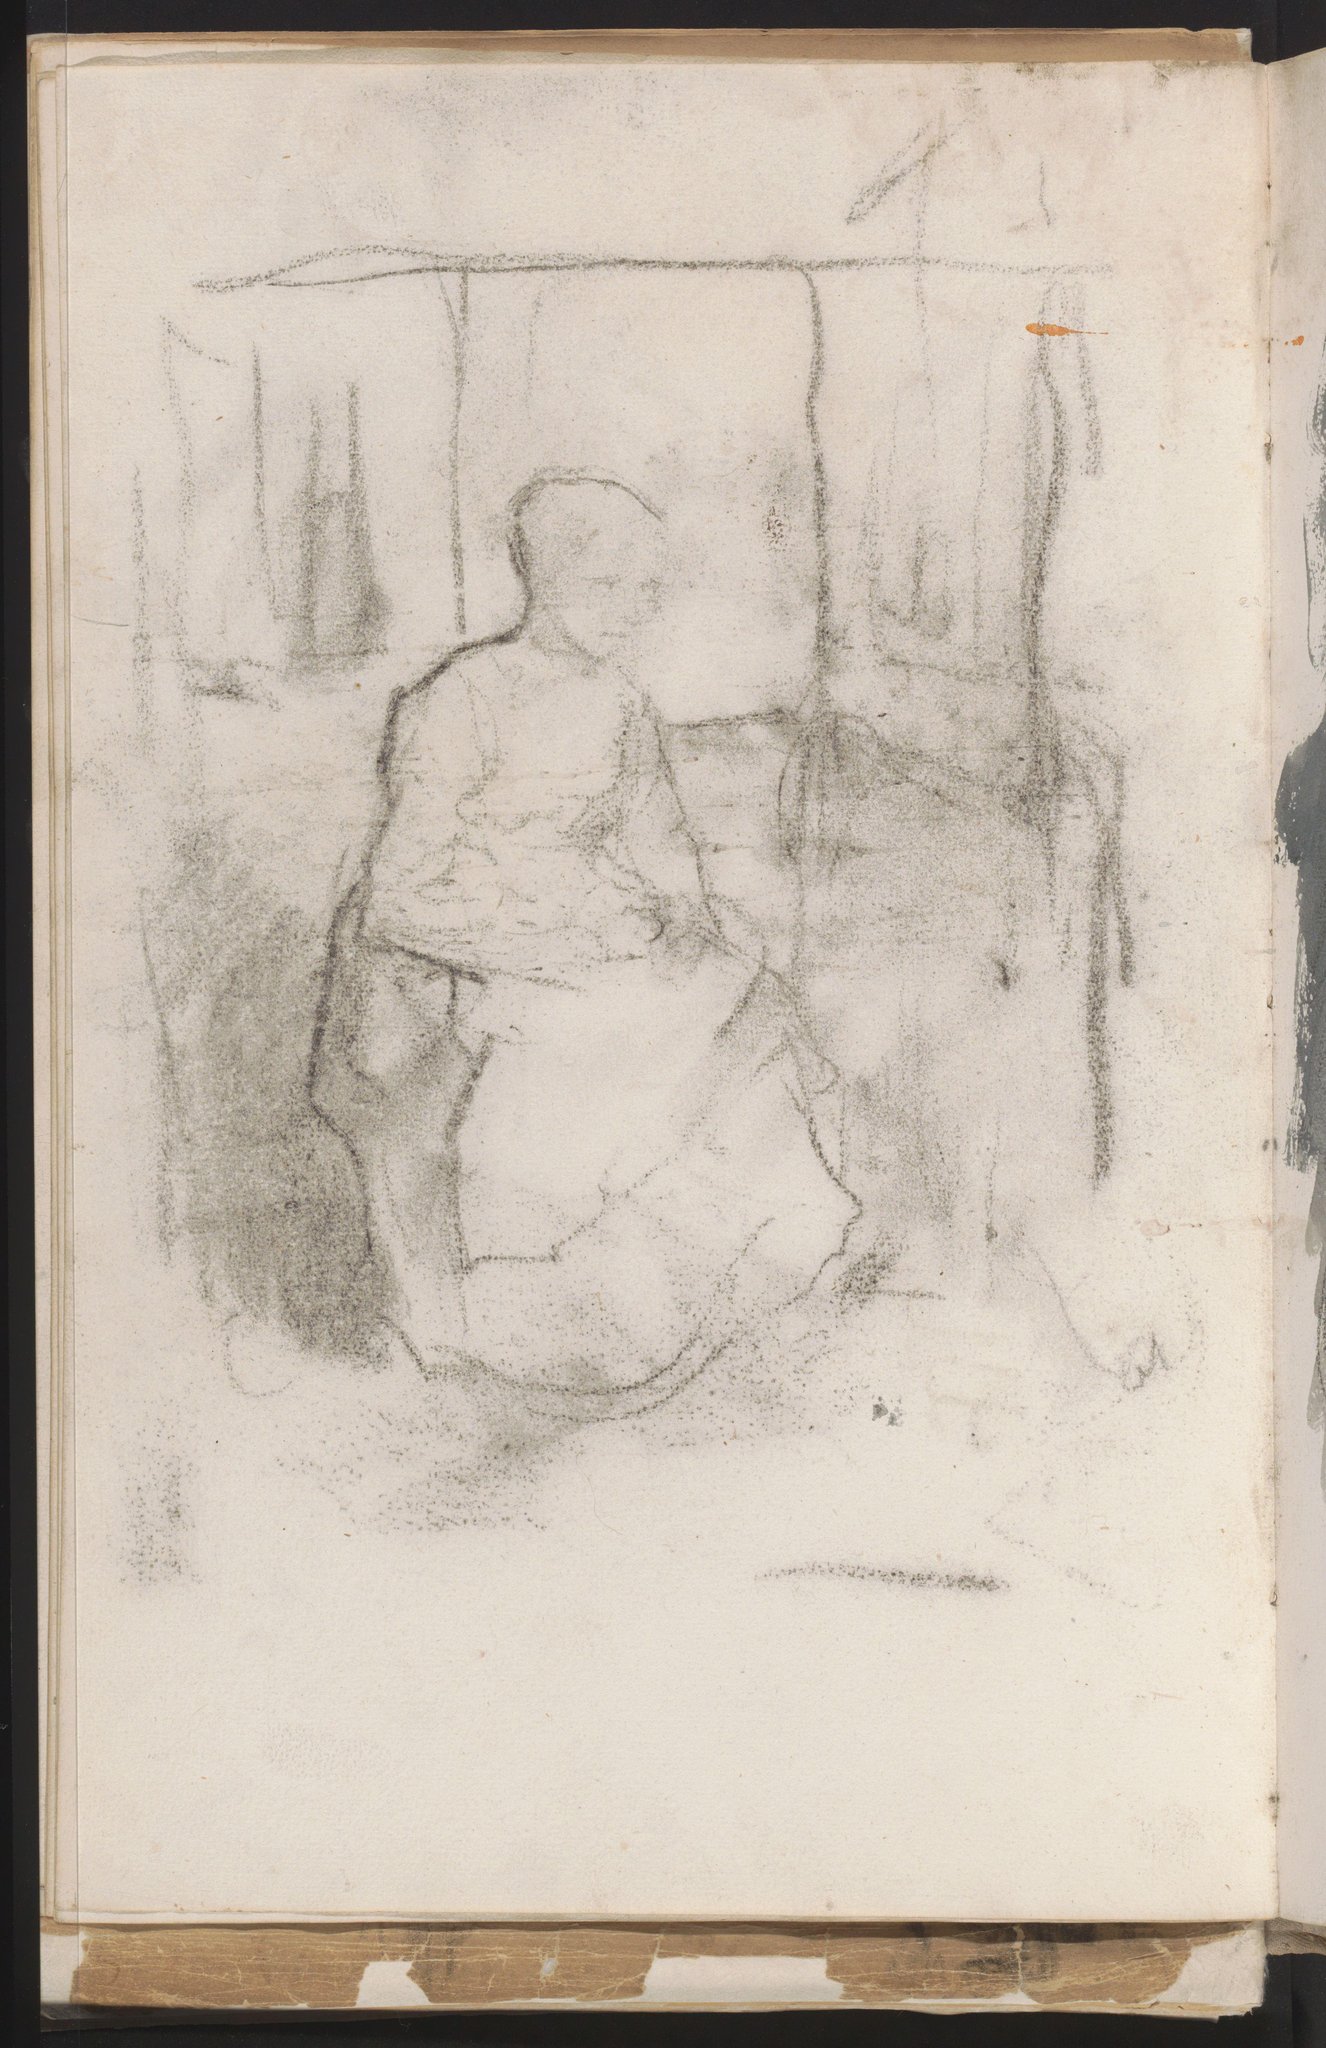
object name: sketchbook leaf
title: Jonge vrouw zittend in een interieur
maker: albert neuhuys (1844-1914)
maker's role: draughtsman, painter, print maker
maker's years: 1844-1914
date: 1854-1914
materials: charcoal, paper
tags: sitting figure, adult woman, interior of the house, apron (+ women's clothes)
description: De vrouw draagt een schort en muts. Blad 26 verso uit een schetsboek met 53 bladen.